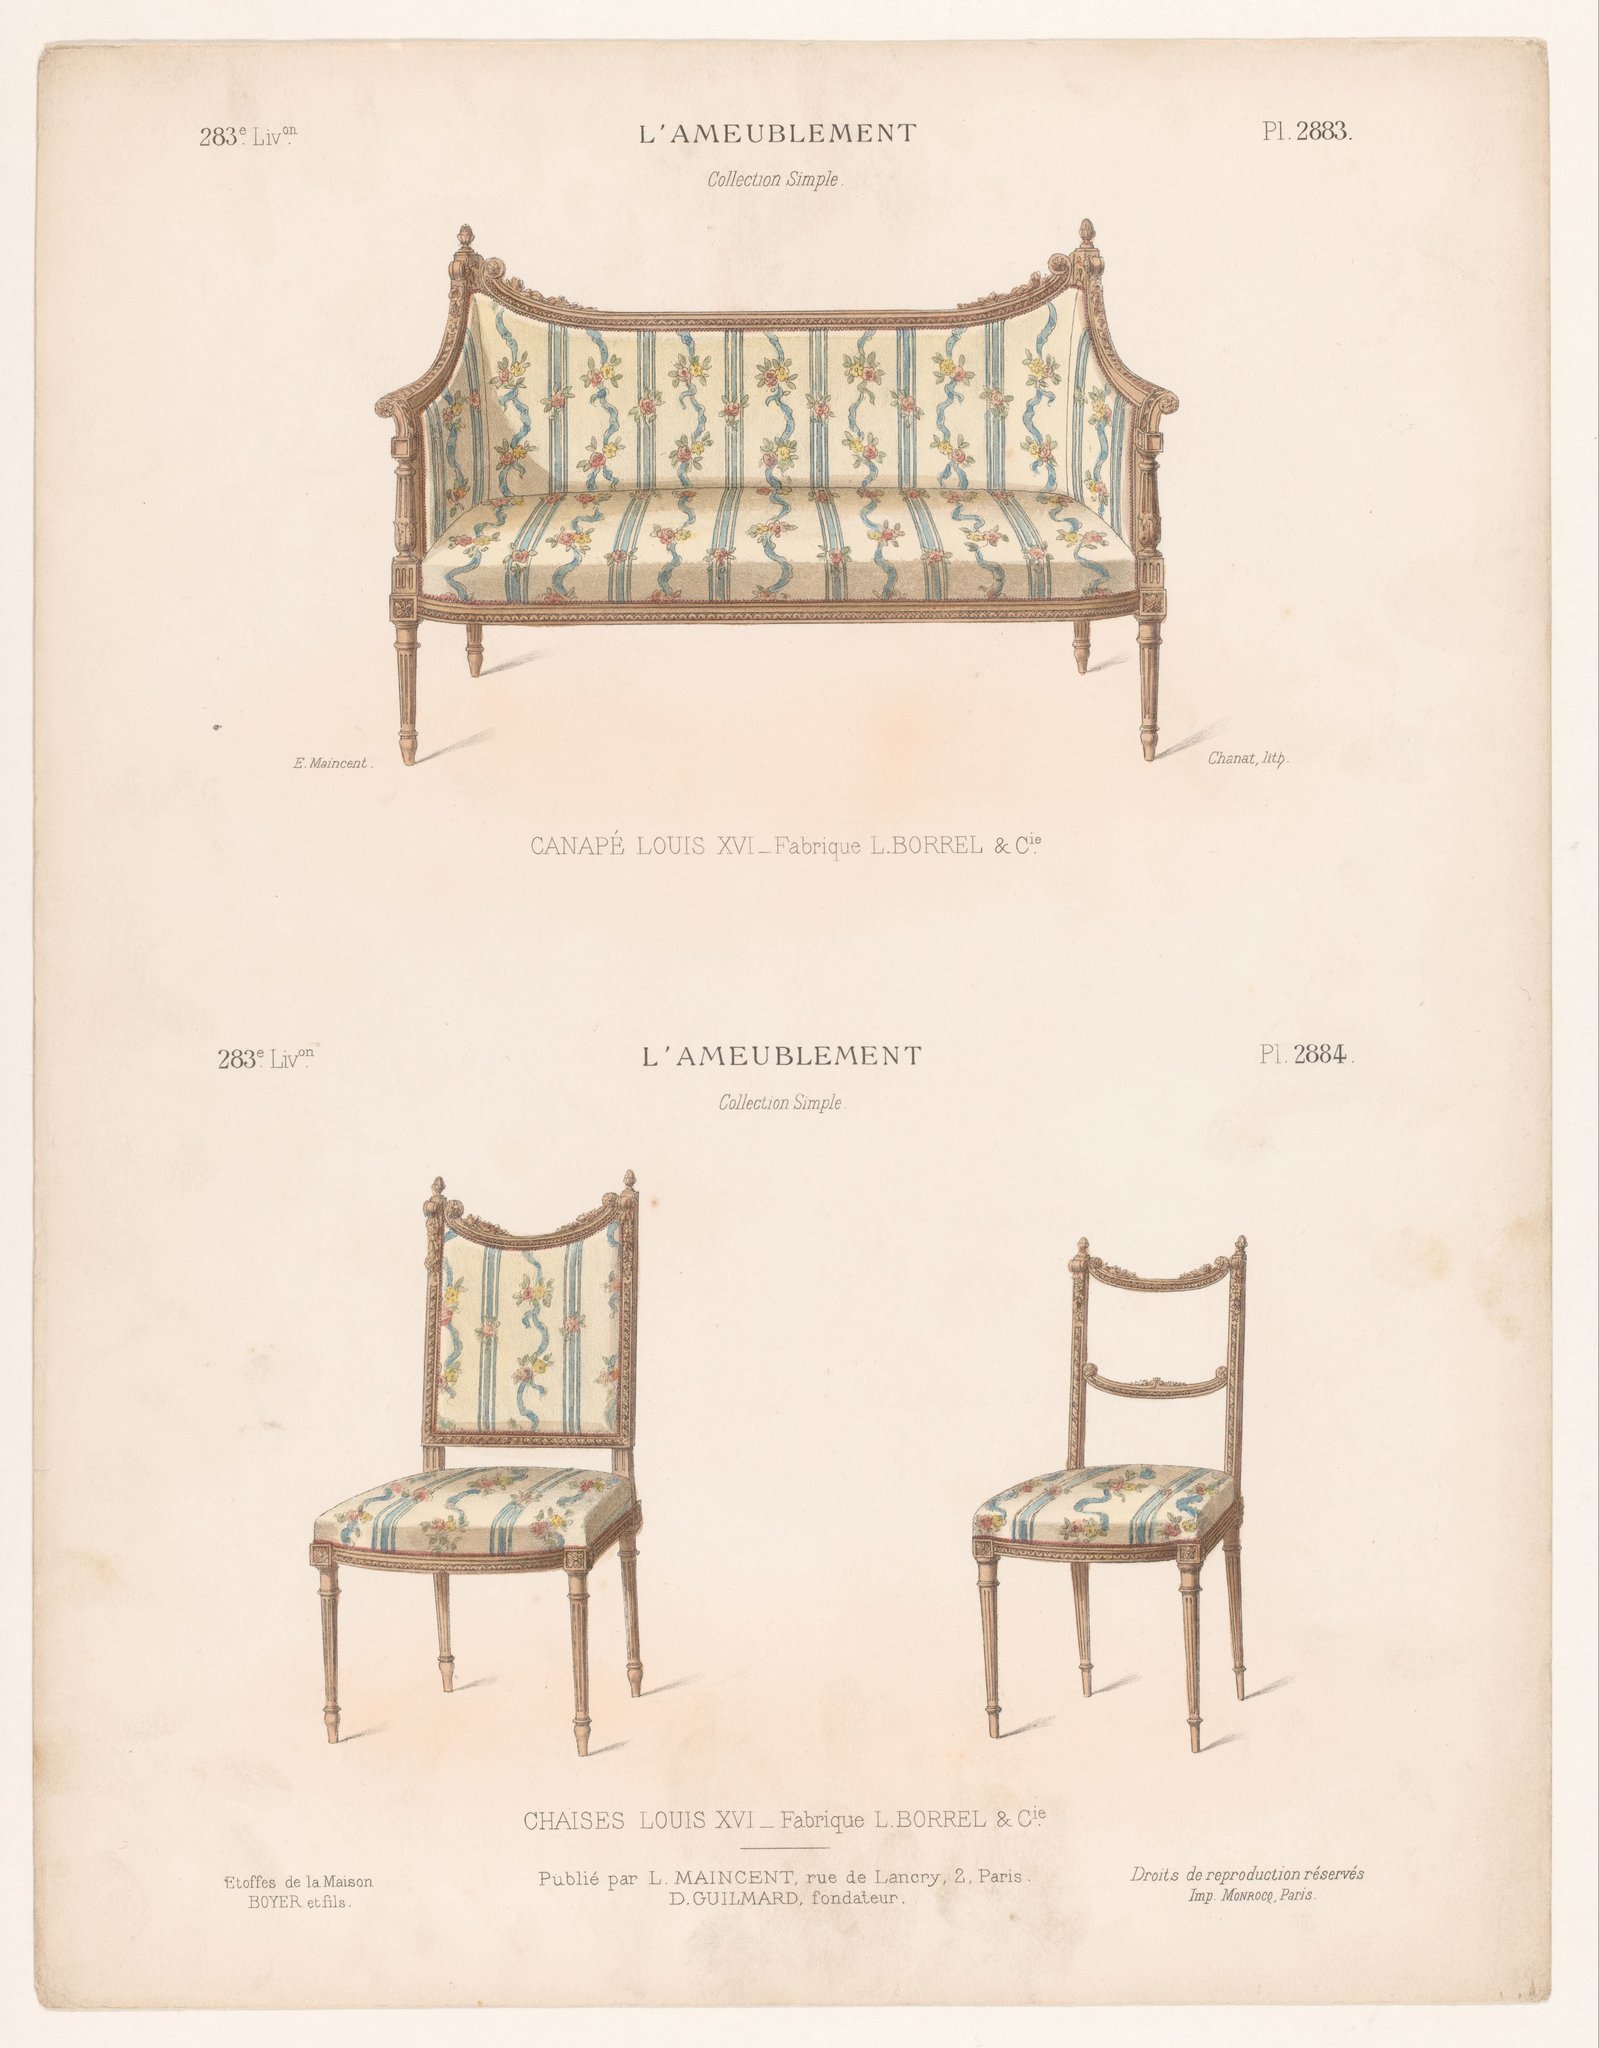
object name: print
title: L'ameublement / Collection simple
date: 1885-1895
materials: paper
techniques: hand coloring, lithograph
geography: paris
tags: seating furniture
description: Een canapé en twee stoelen in de Lodewijk XVI-stijl. Prent uit 283e Livraison.